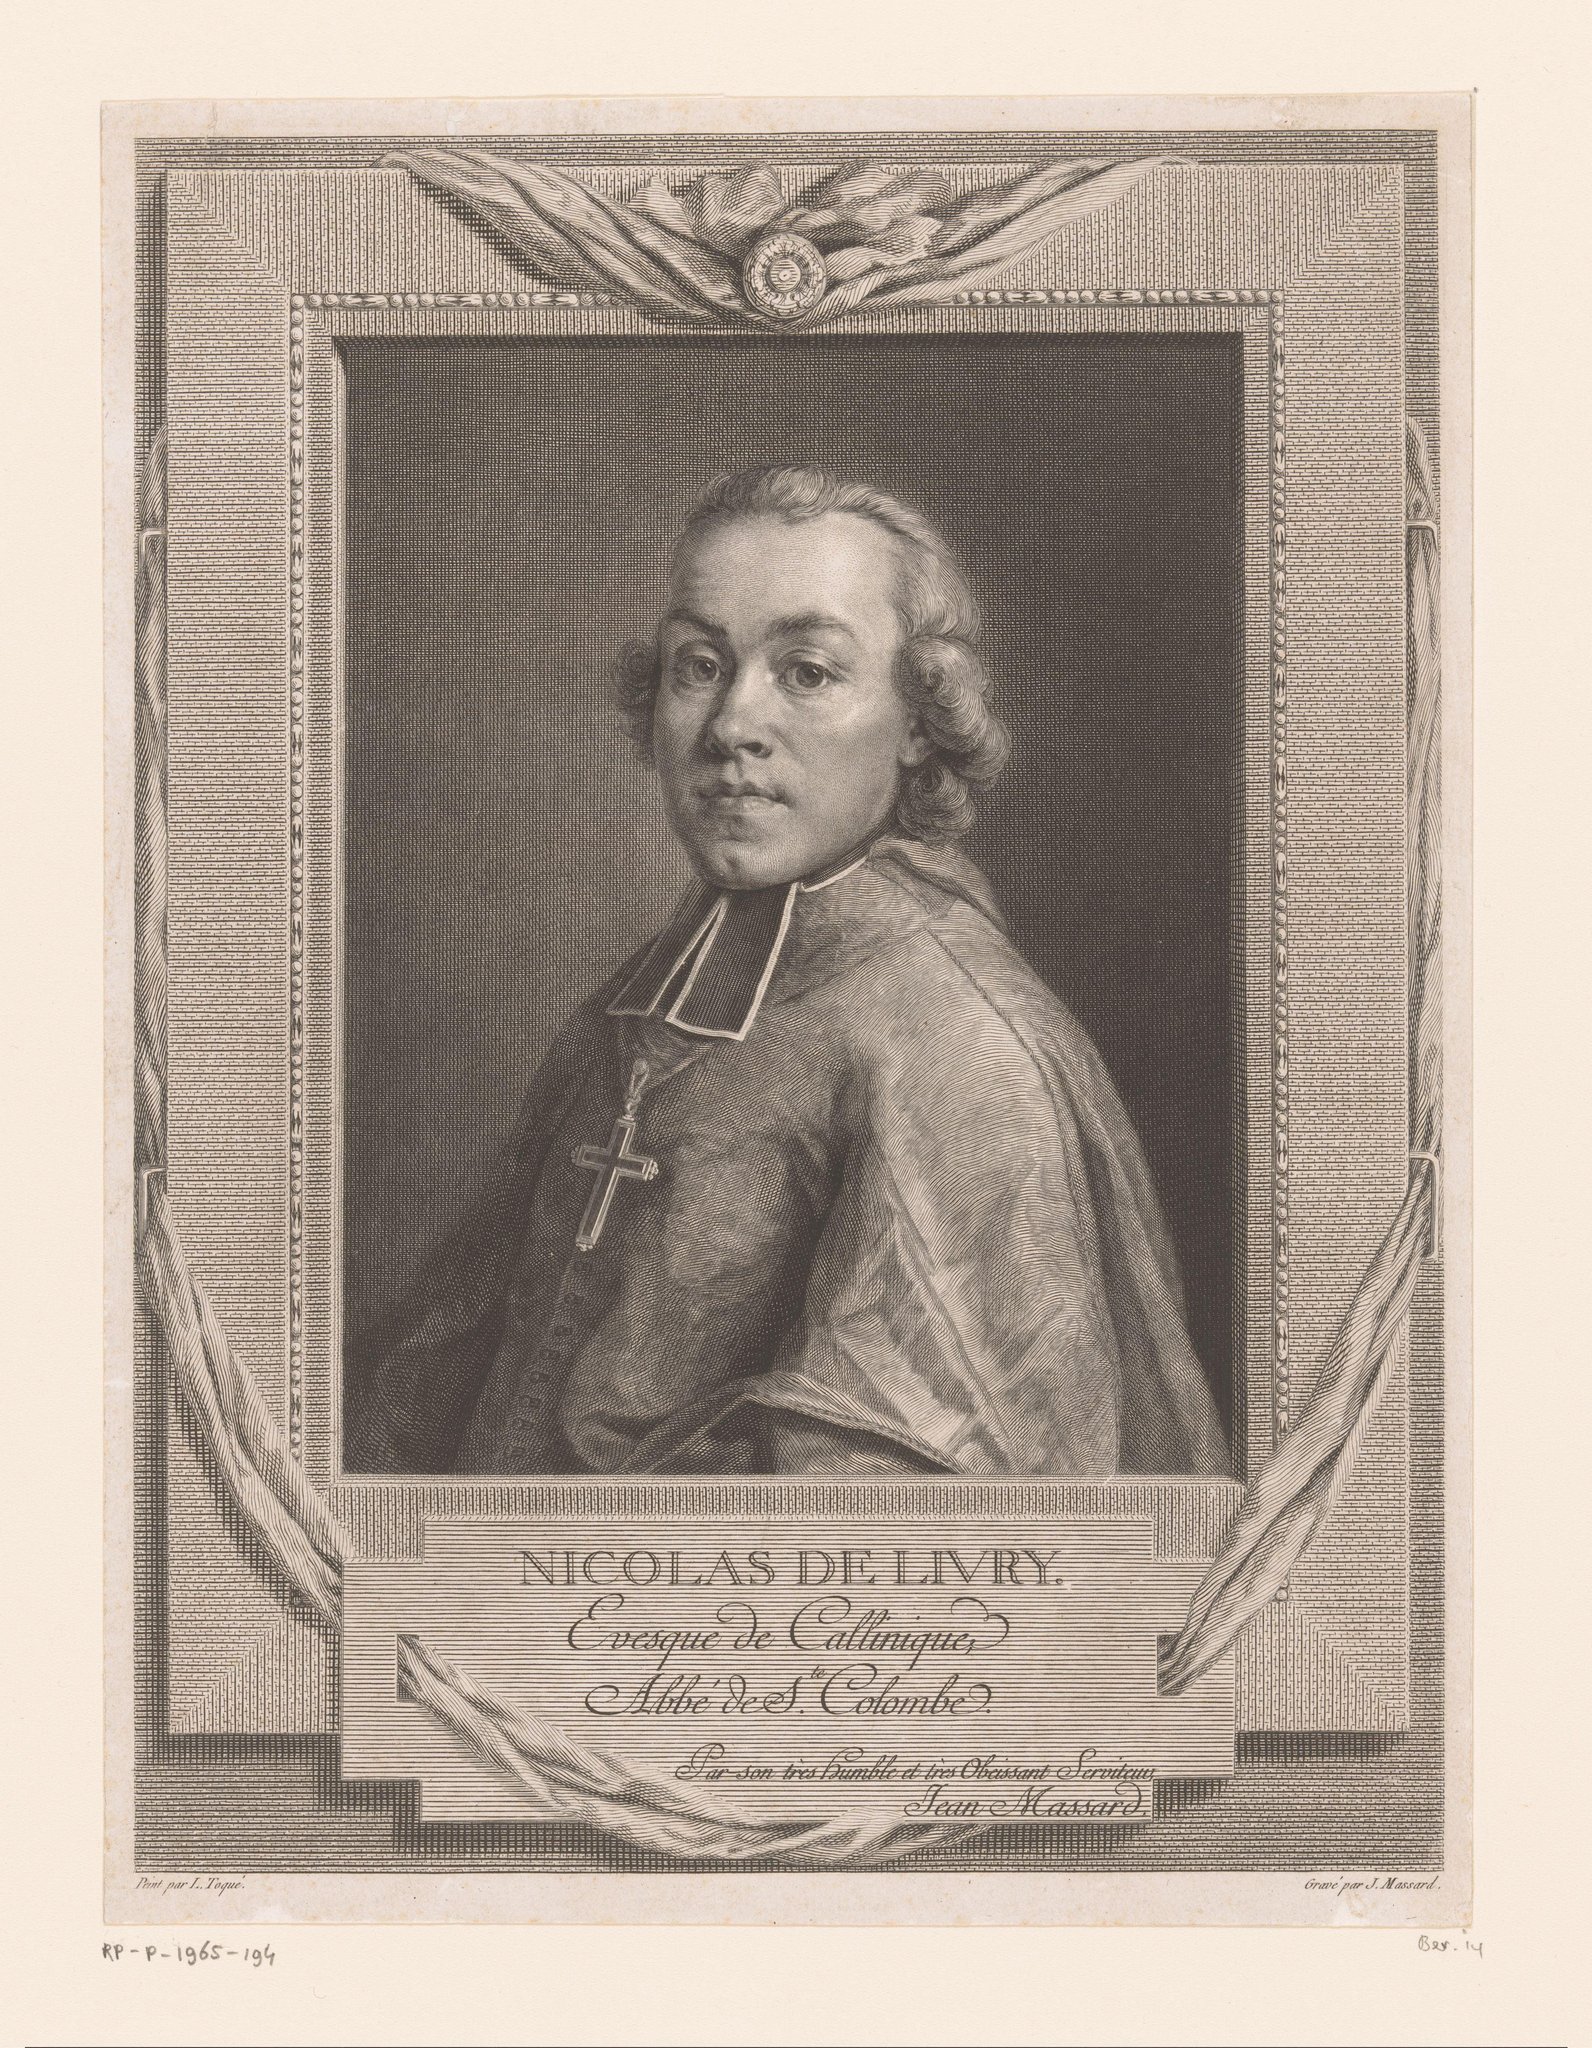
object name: print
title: Portret van Nicolas La Pinte de Livry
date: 1782-1812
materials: paper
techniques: engraving, etching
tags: nicolas la pinte de livry, historical persons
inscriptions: collector's mark: Lugt 2760, collector's mark: Lugt 2228